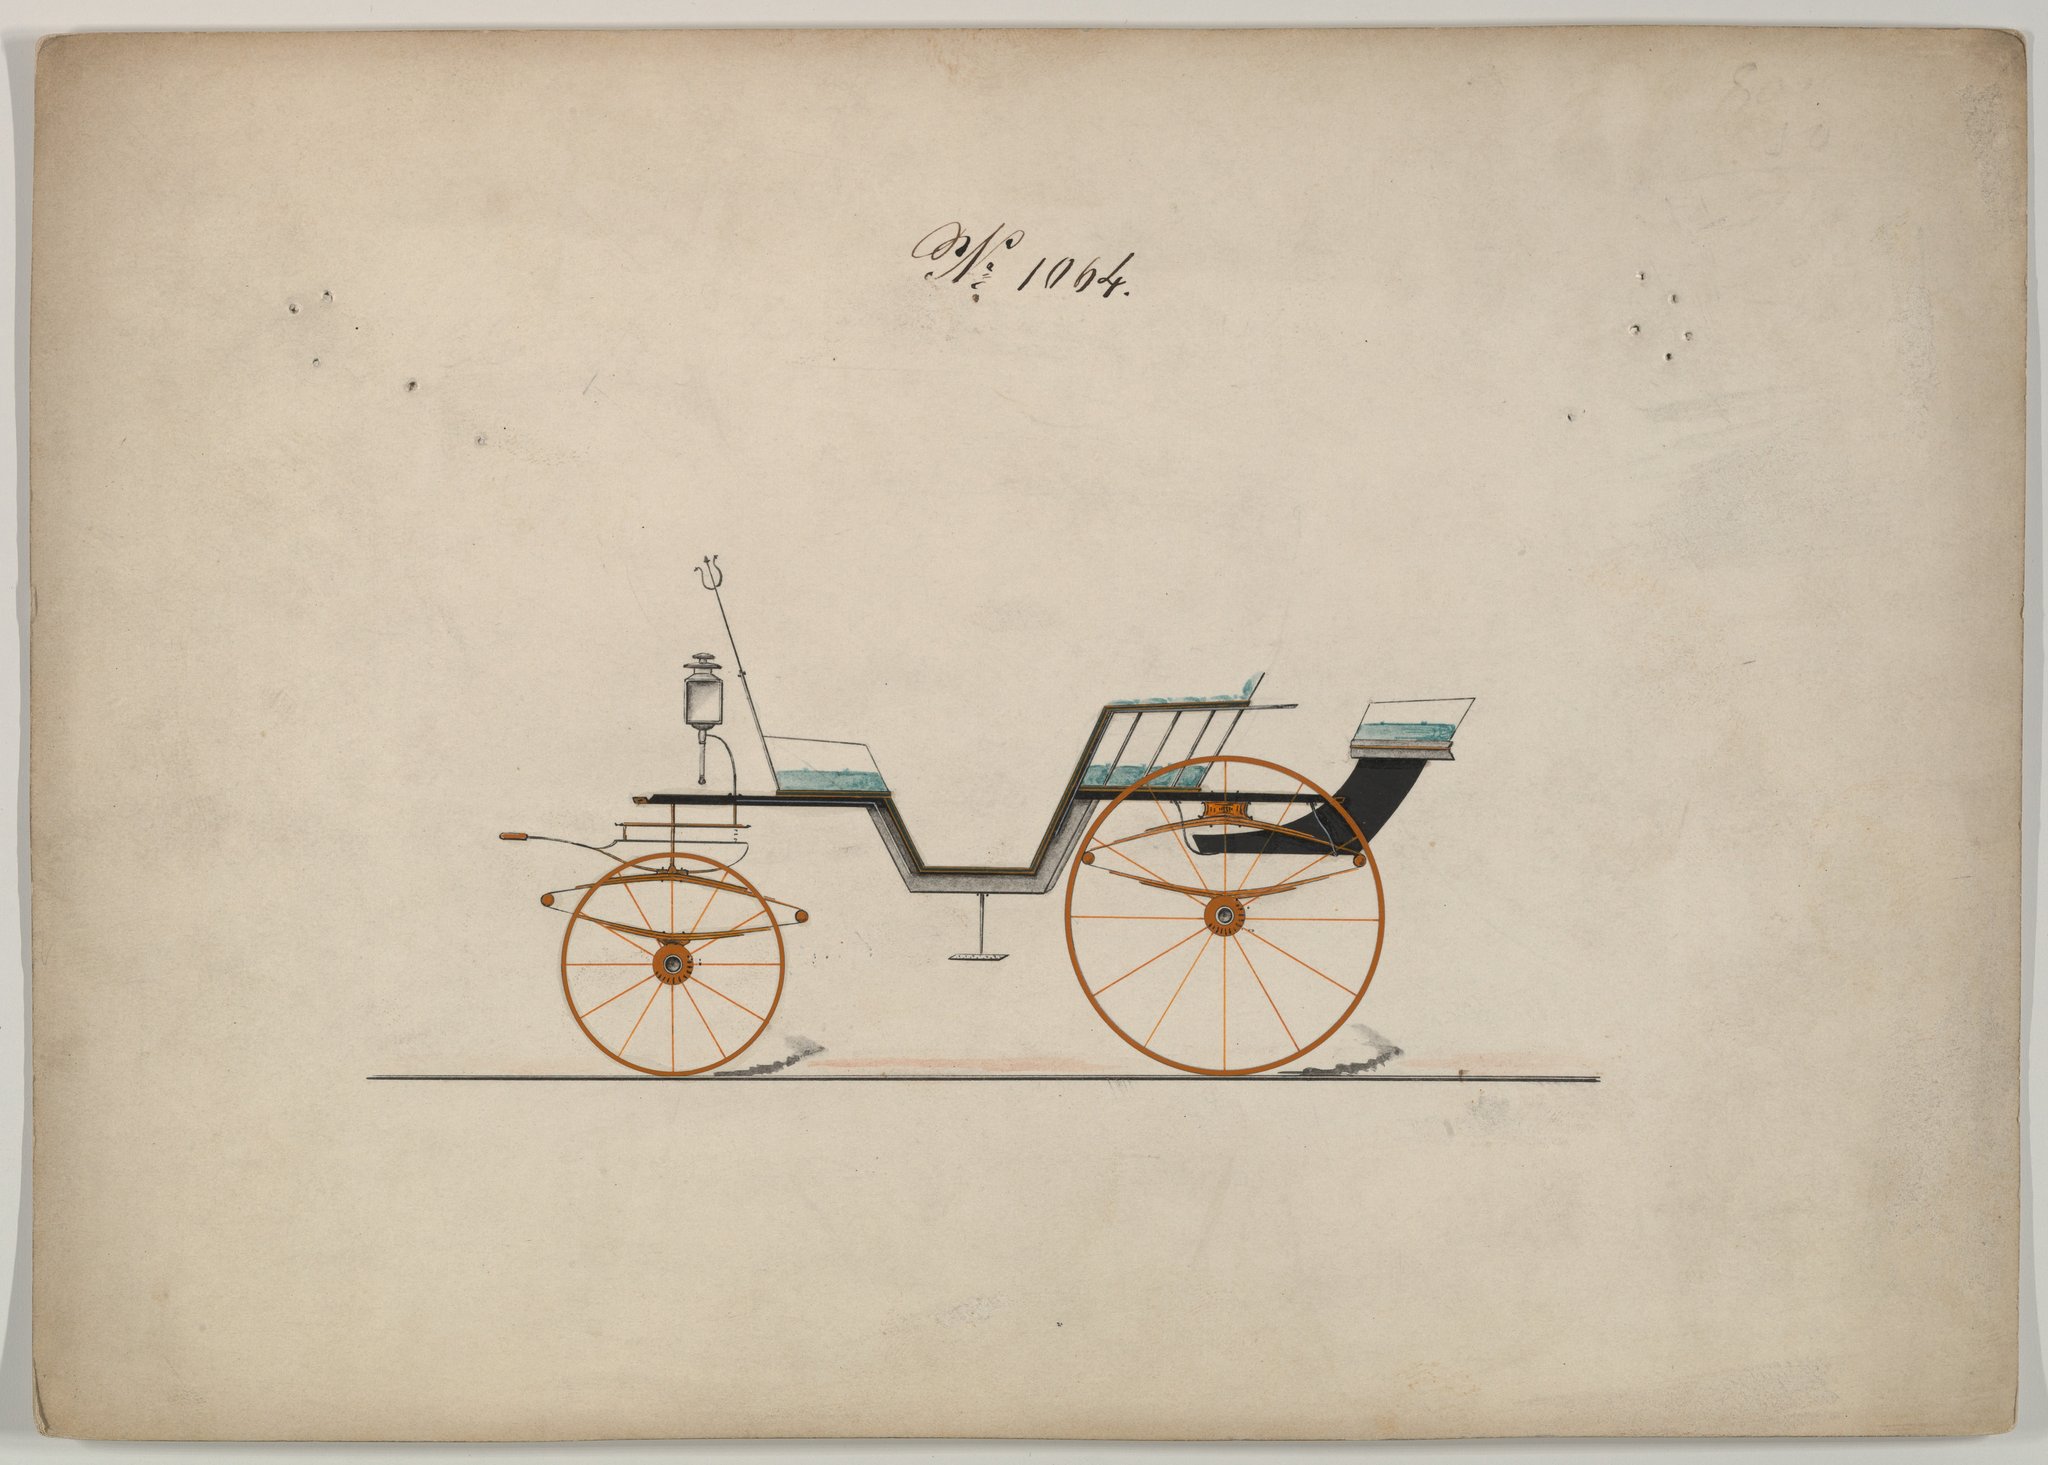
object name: drawing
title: Design for Two Seat English Pony Phaeton, no. 1064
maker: brewster & co.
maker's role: manufacturer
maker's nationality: american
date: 1850-1874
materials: gouache, gum arabic, ink, watercolor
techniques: pen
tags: carriages